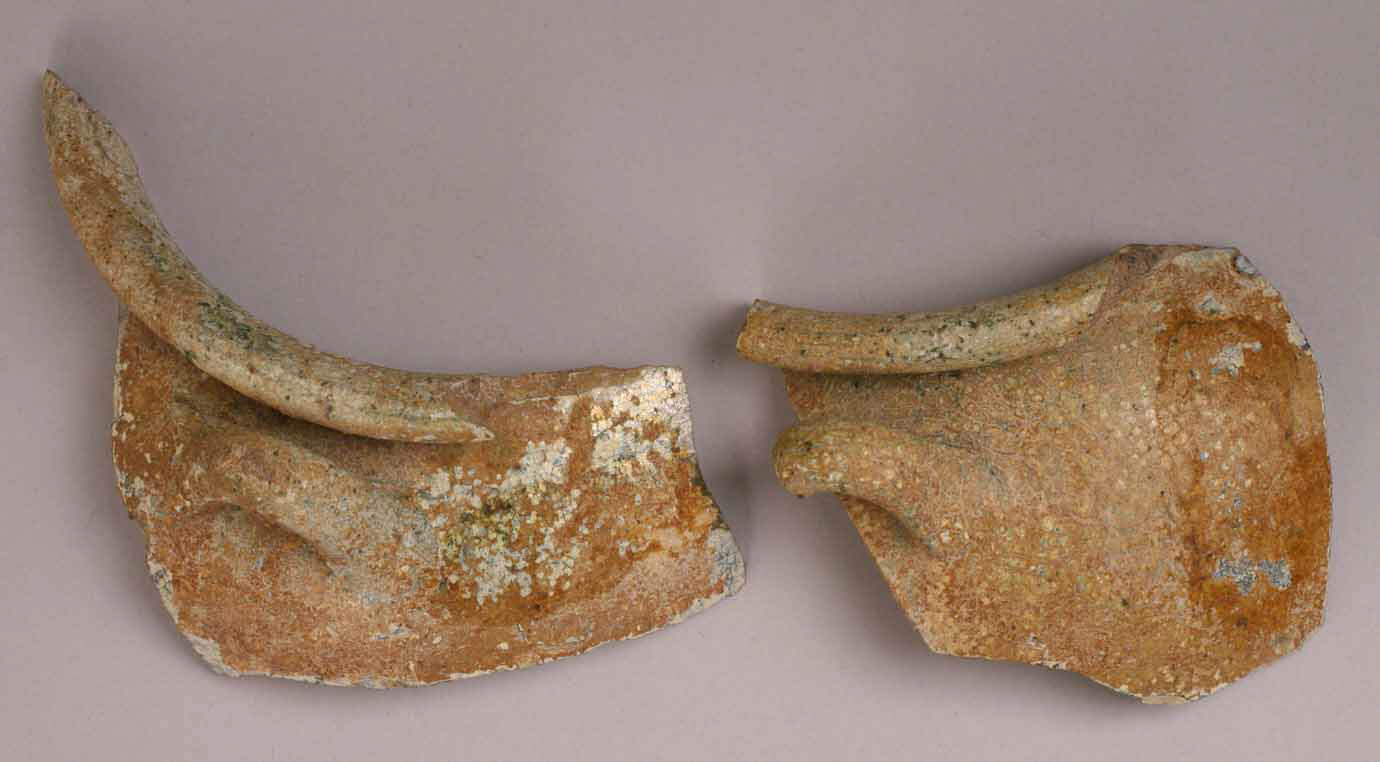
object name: fragment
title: Ceramic Fragment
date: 801-1000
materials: earthenware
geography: saudi arabia